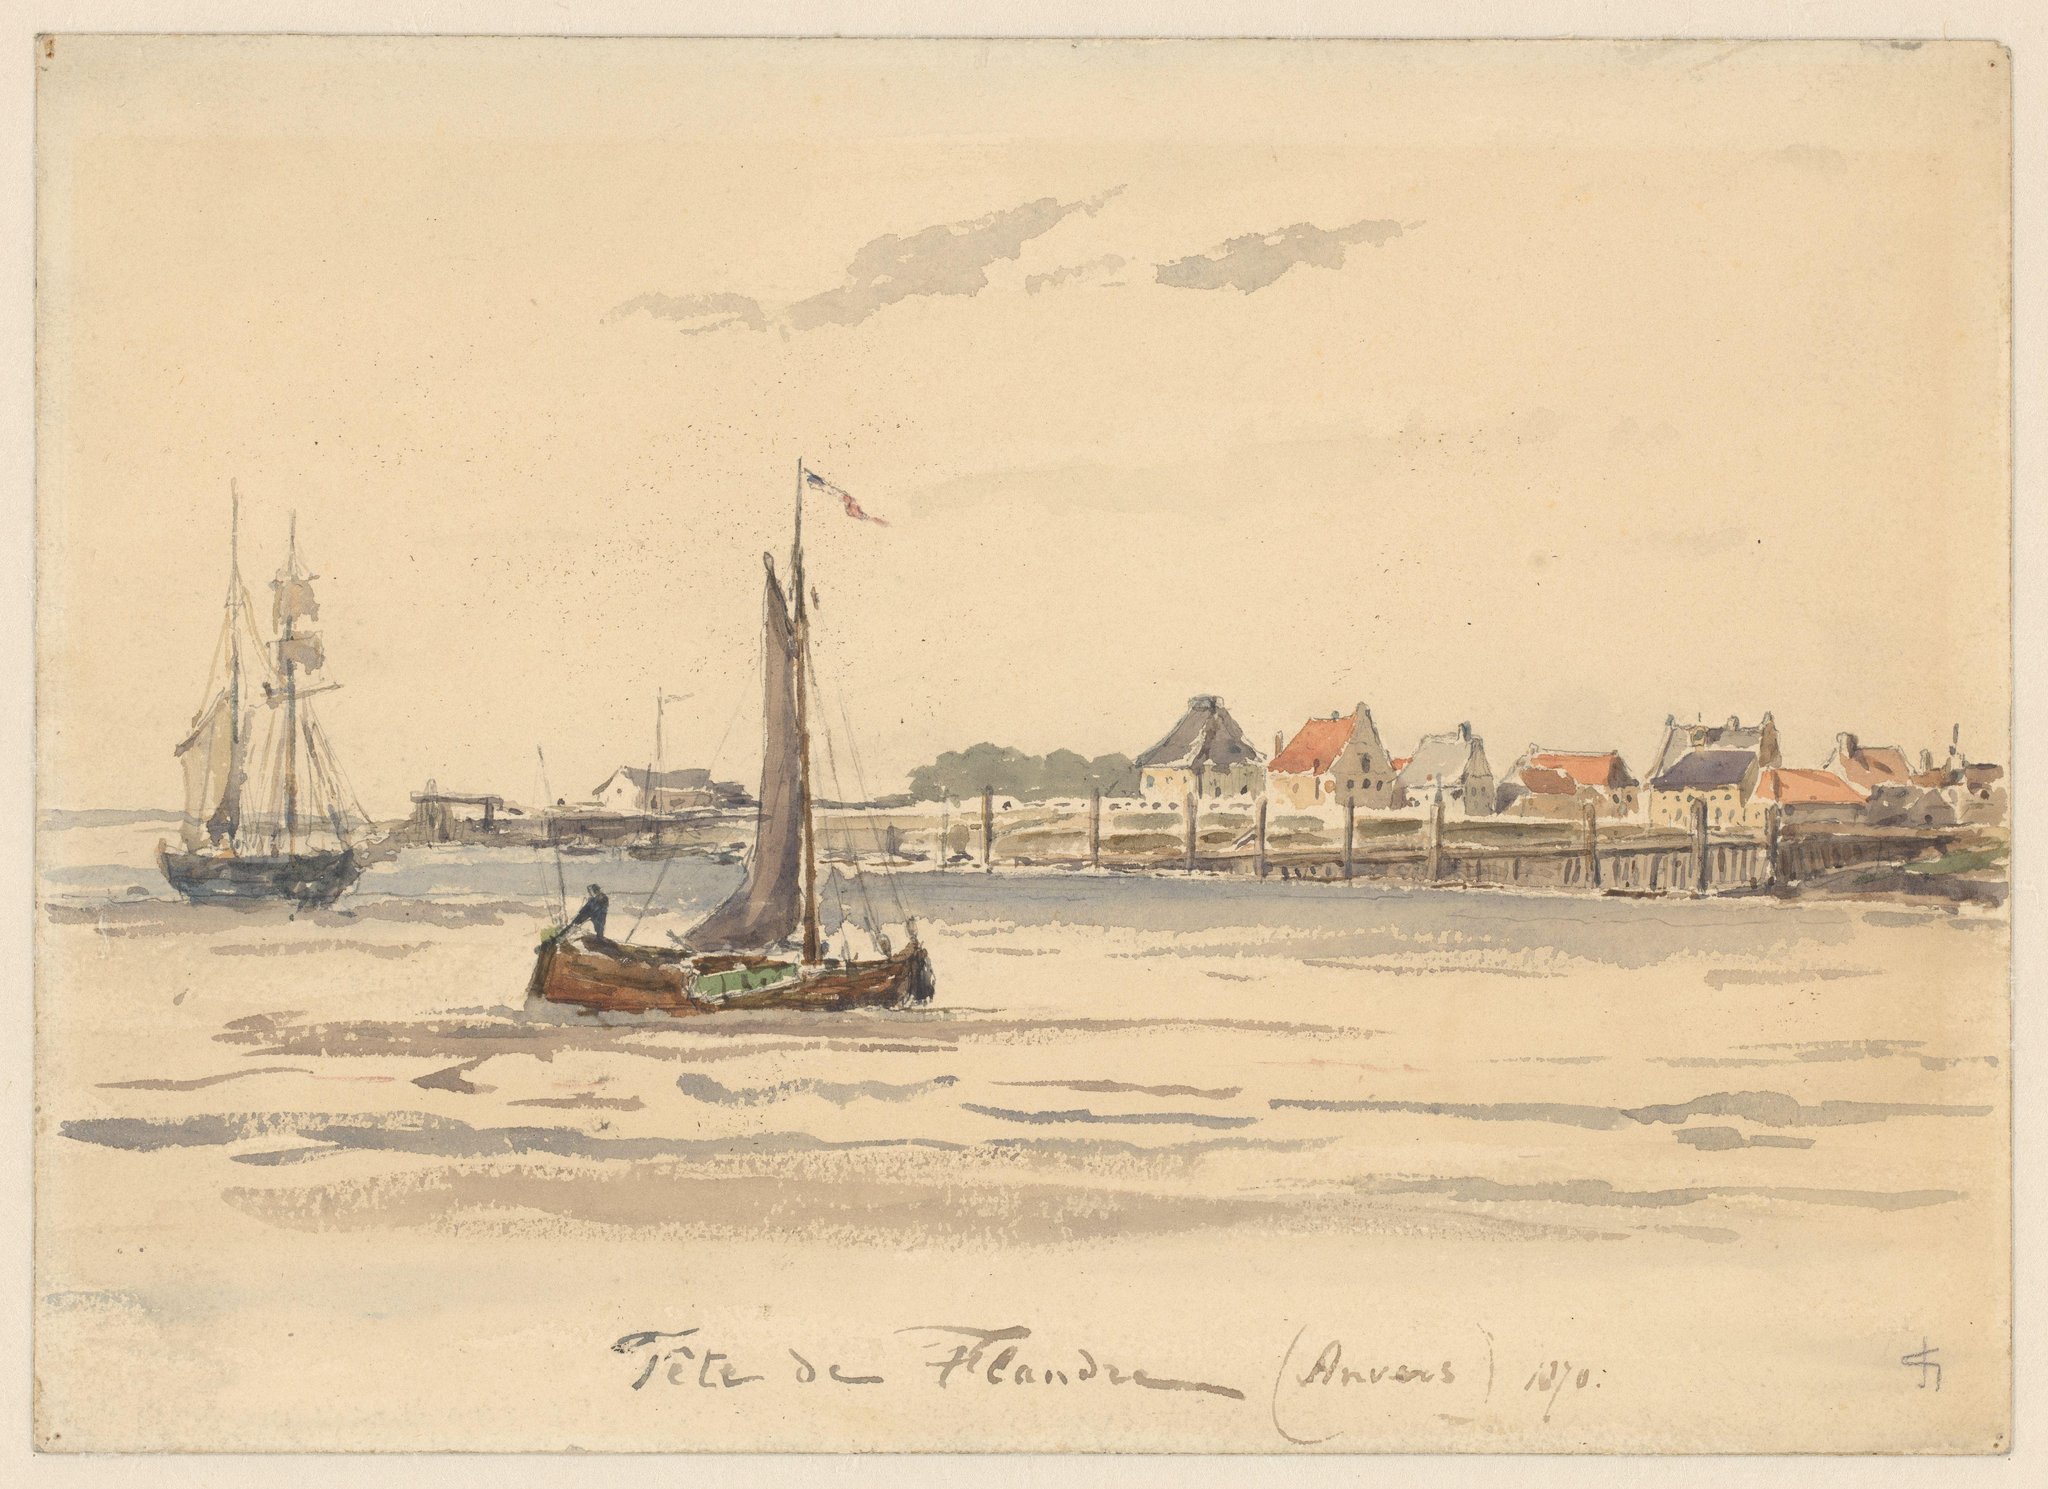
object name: drawing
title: Gezicht te Antwerpen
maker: carel nicolaas storm van s-gravesande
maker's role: draughtsman, print maker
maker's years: 1841-1924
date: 1870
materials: paper, pencil, watercolor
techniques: brush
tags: public road, antwerp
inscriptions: annotation: ‘Tête de Flandre’